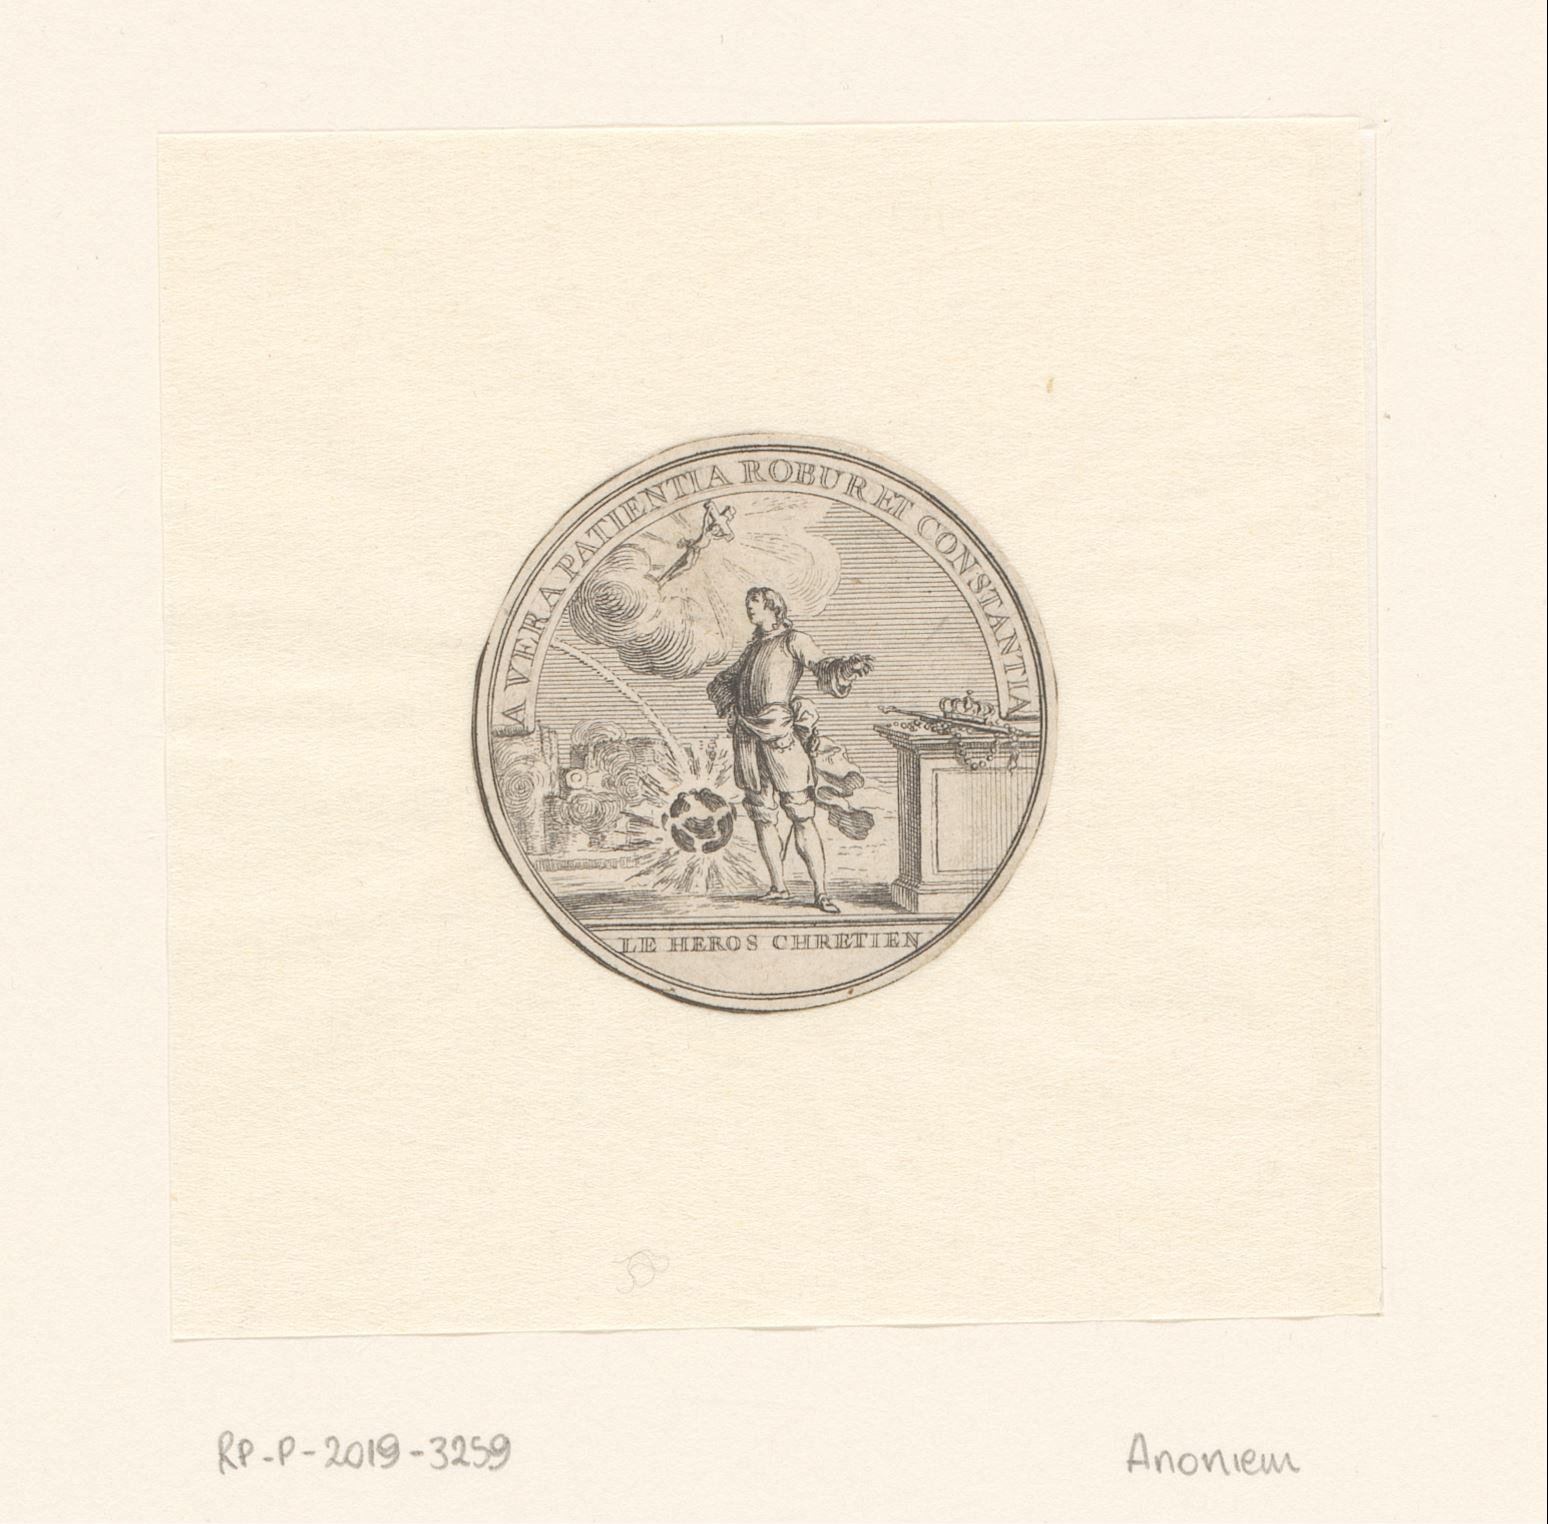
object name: print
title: Christelijke Ridder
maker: Anonymous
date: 1650-1750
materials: paper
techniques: etching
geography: france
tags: comet, the christian knight, 'miles christianus'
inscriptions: collector's mark: Lugt 2228